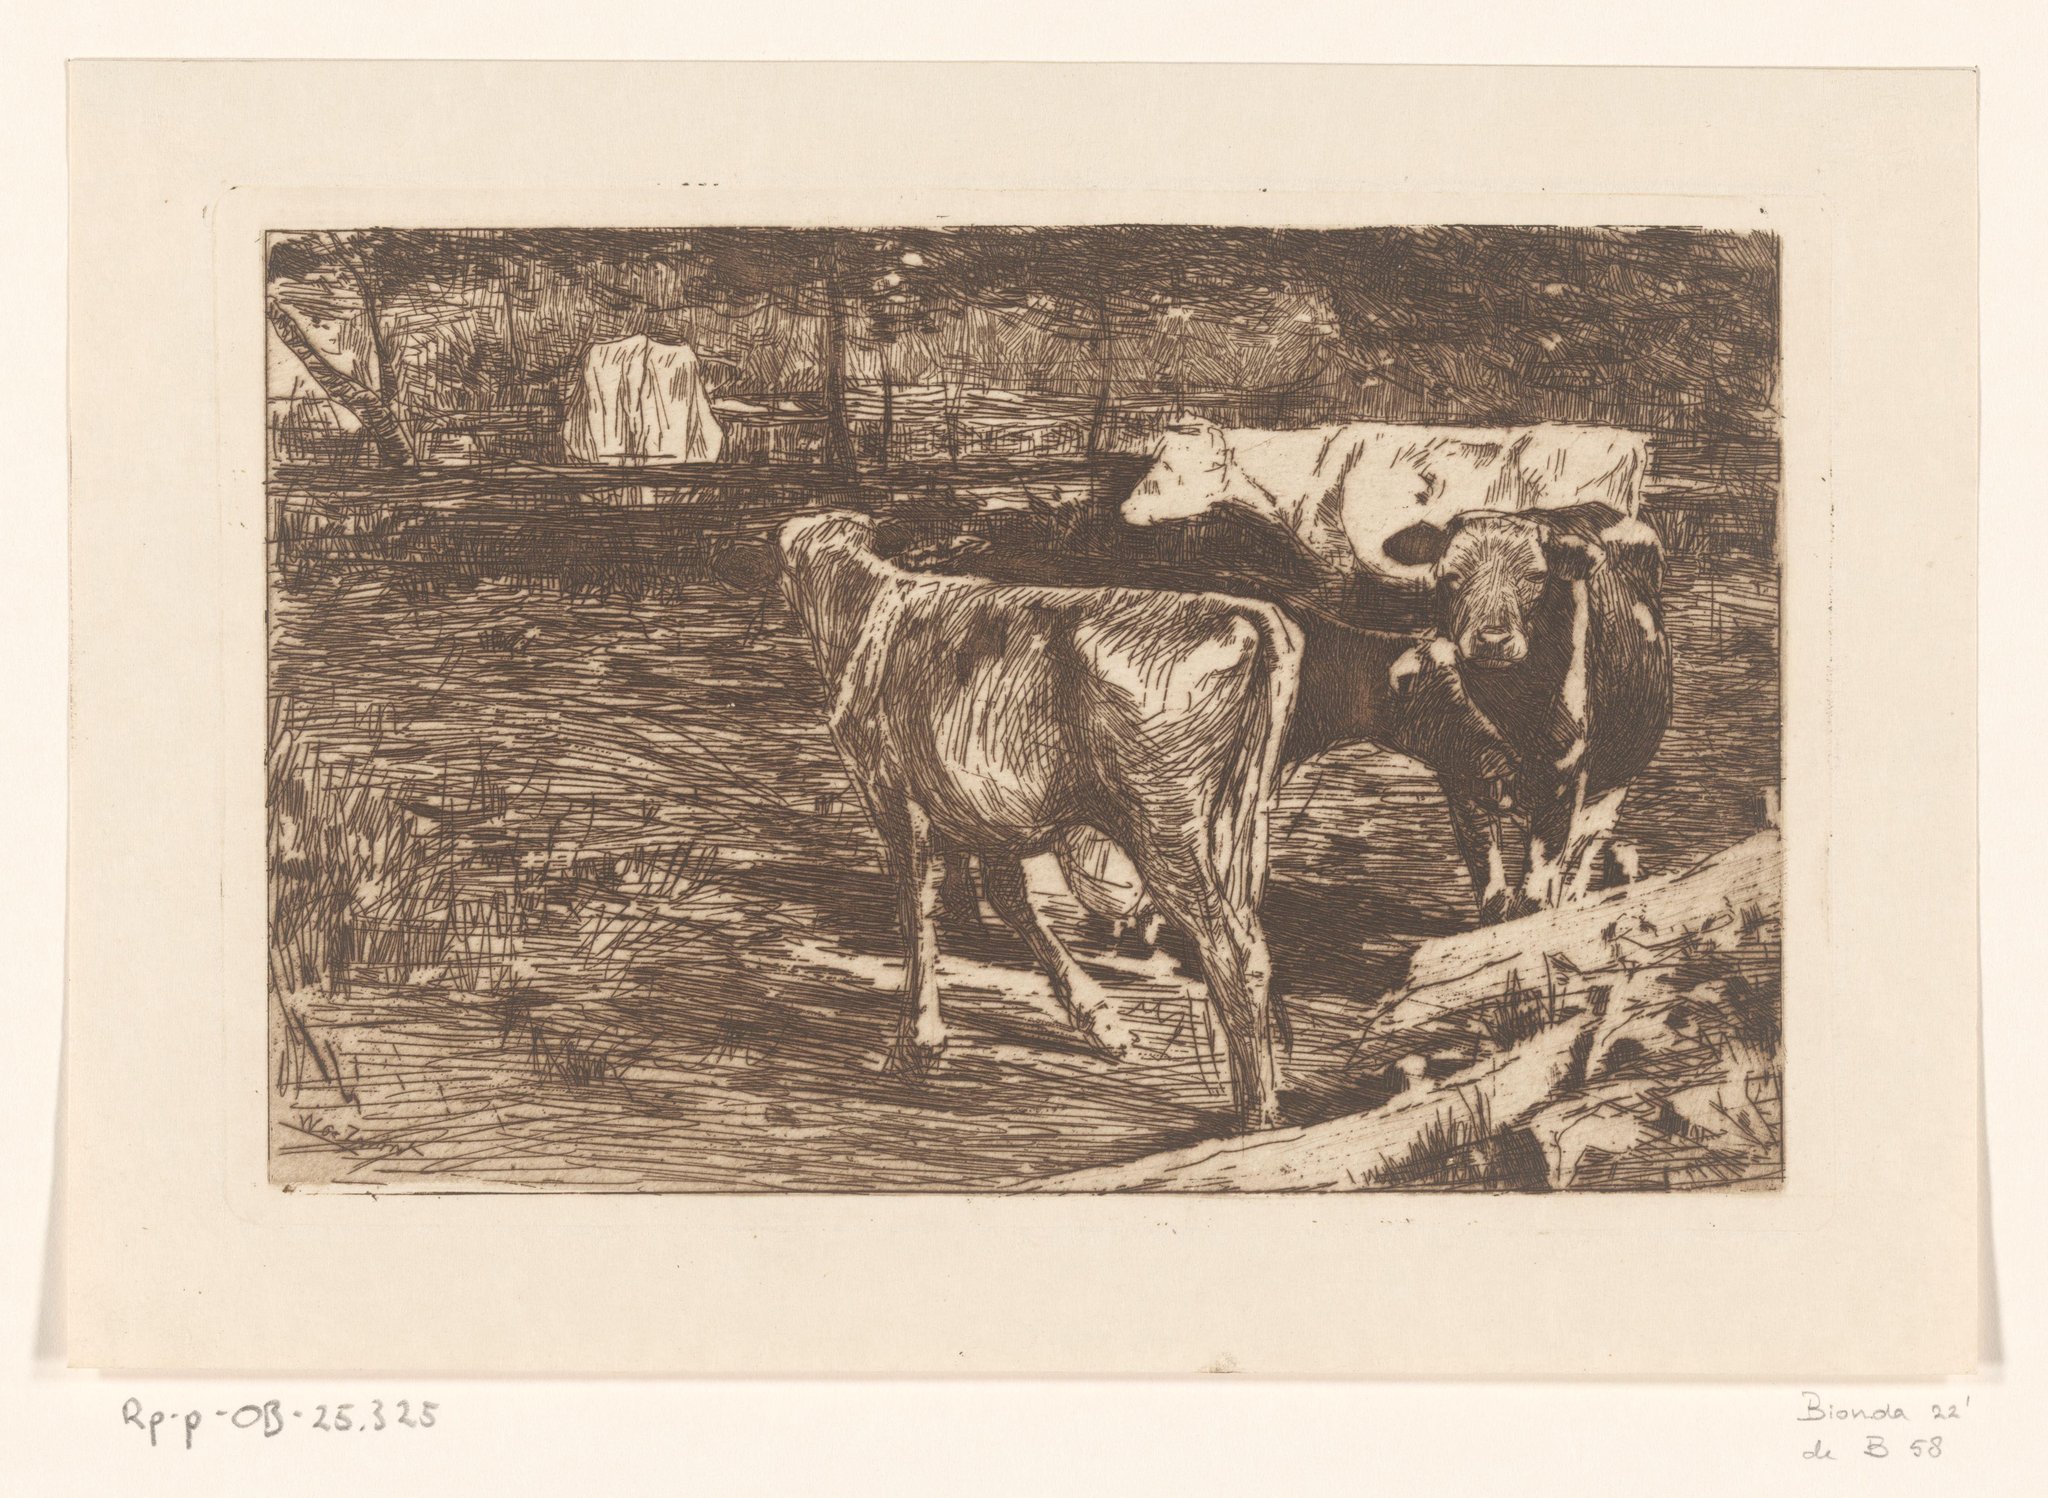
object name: print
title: Vier koeien in een weide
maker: willem de zwart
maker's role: draughtsman, painter, print maker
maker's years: 1862-1931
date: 1885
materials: paper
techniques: drypoint, etching, intaglio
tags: cow, meadow, pasture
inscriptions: collector's mark: Lugt 2228